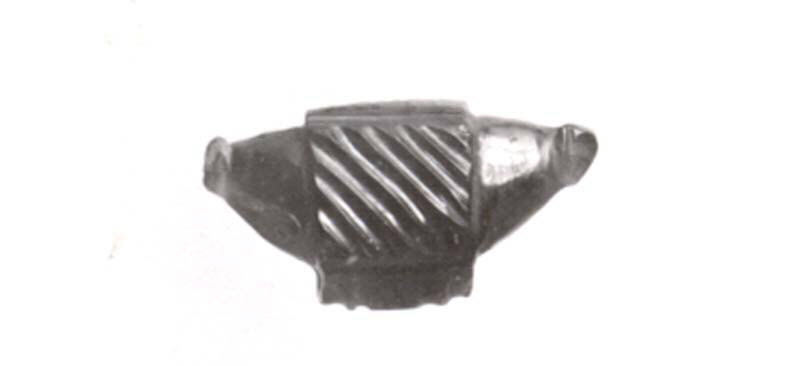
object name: bead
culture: sasanian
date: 201-700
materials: gemstone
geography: iran